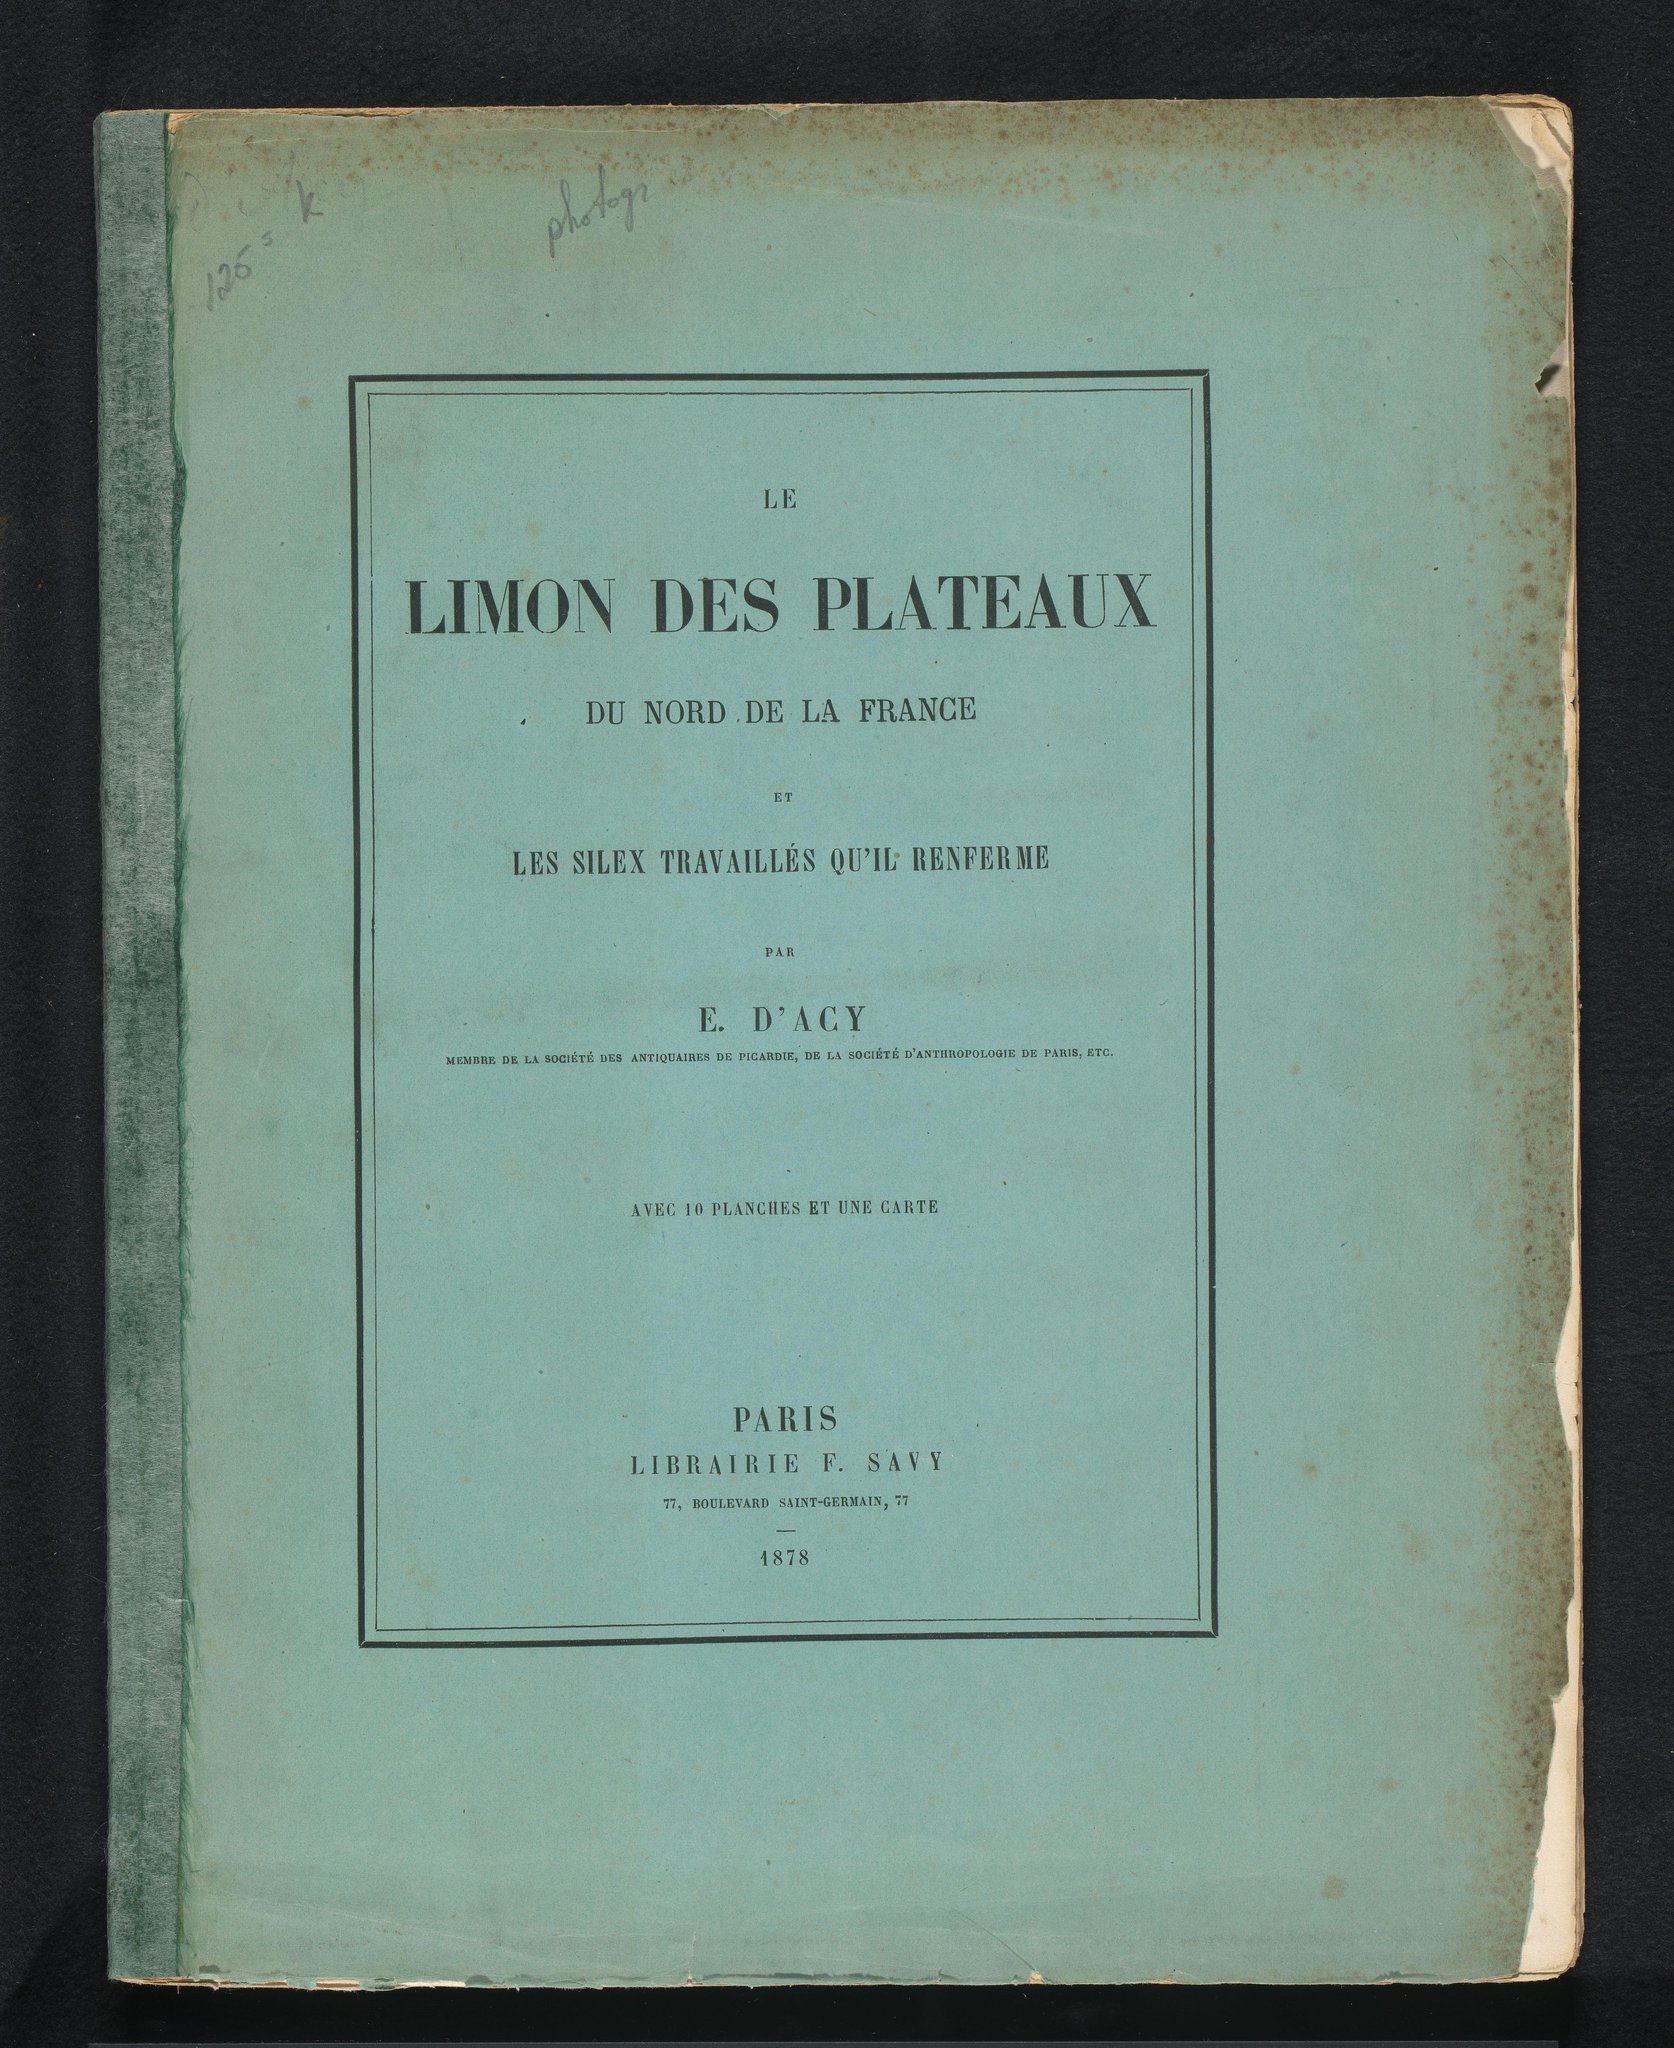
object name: book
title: Le limon des plateaux du nord de la France et les silex travaillés qu'il renferme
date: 1878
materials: cardboard, paper, photographic support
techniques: albumen print, printing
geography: paris